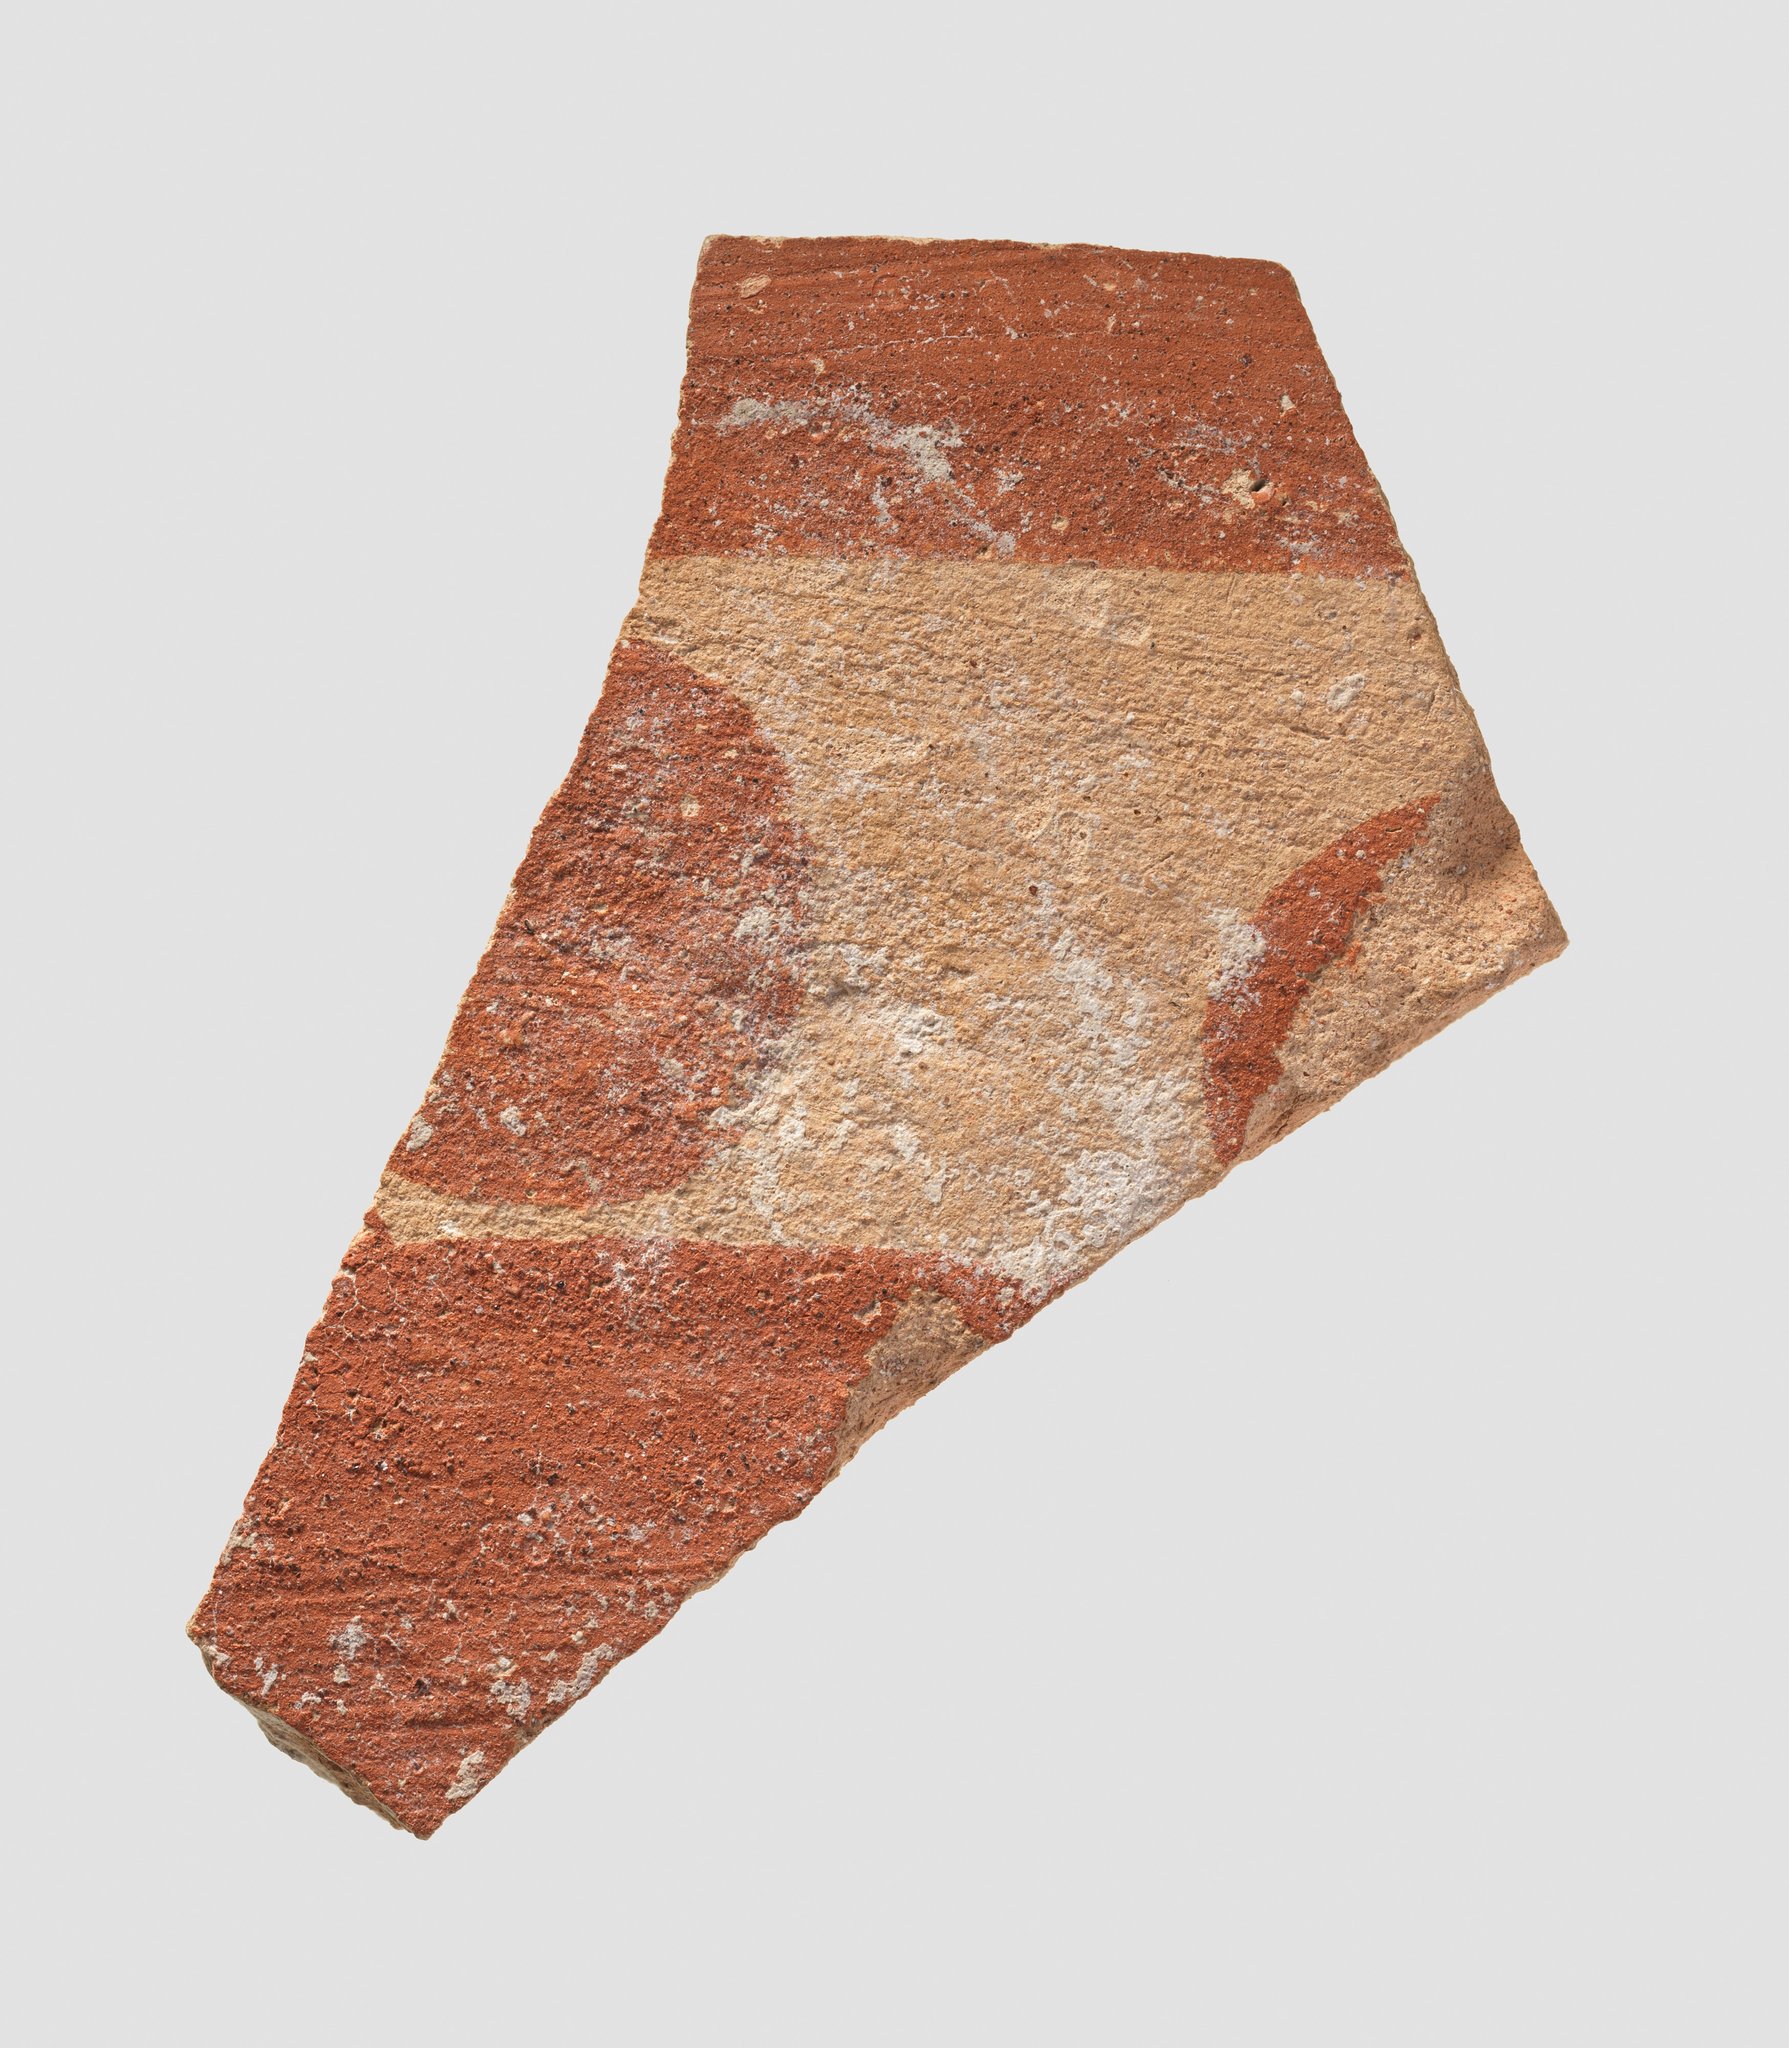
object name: sherd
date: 2000-1668 BCE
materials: ceramic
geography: mesopotamia